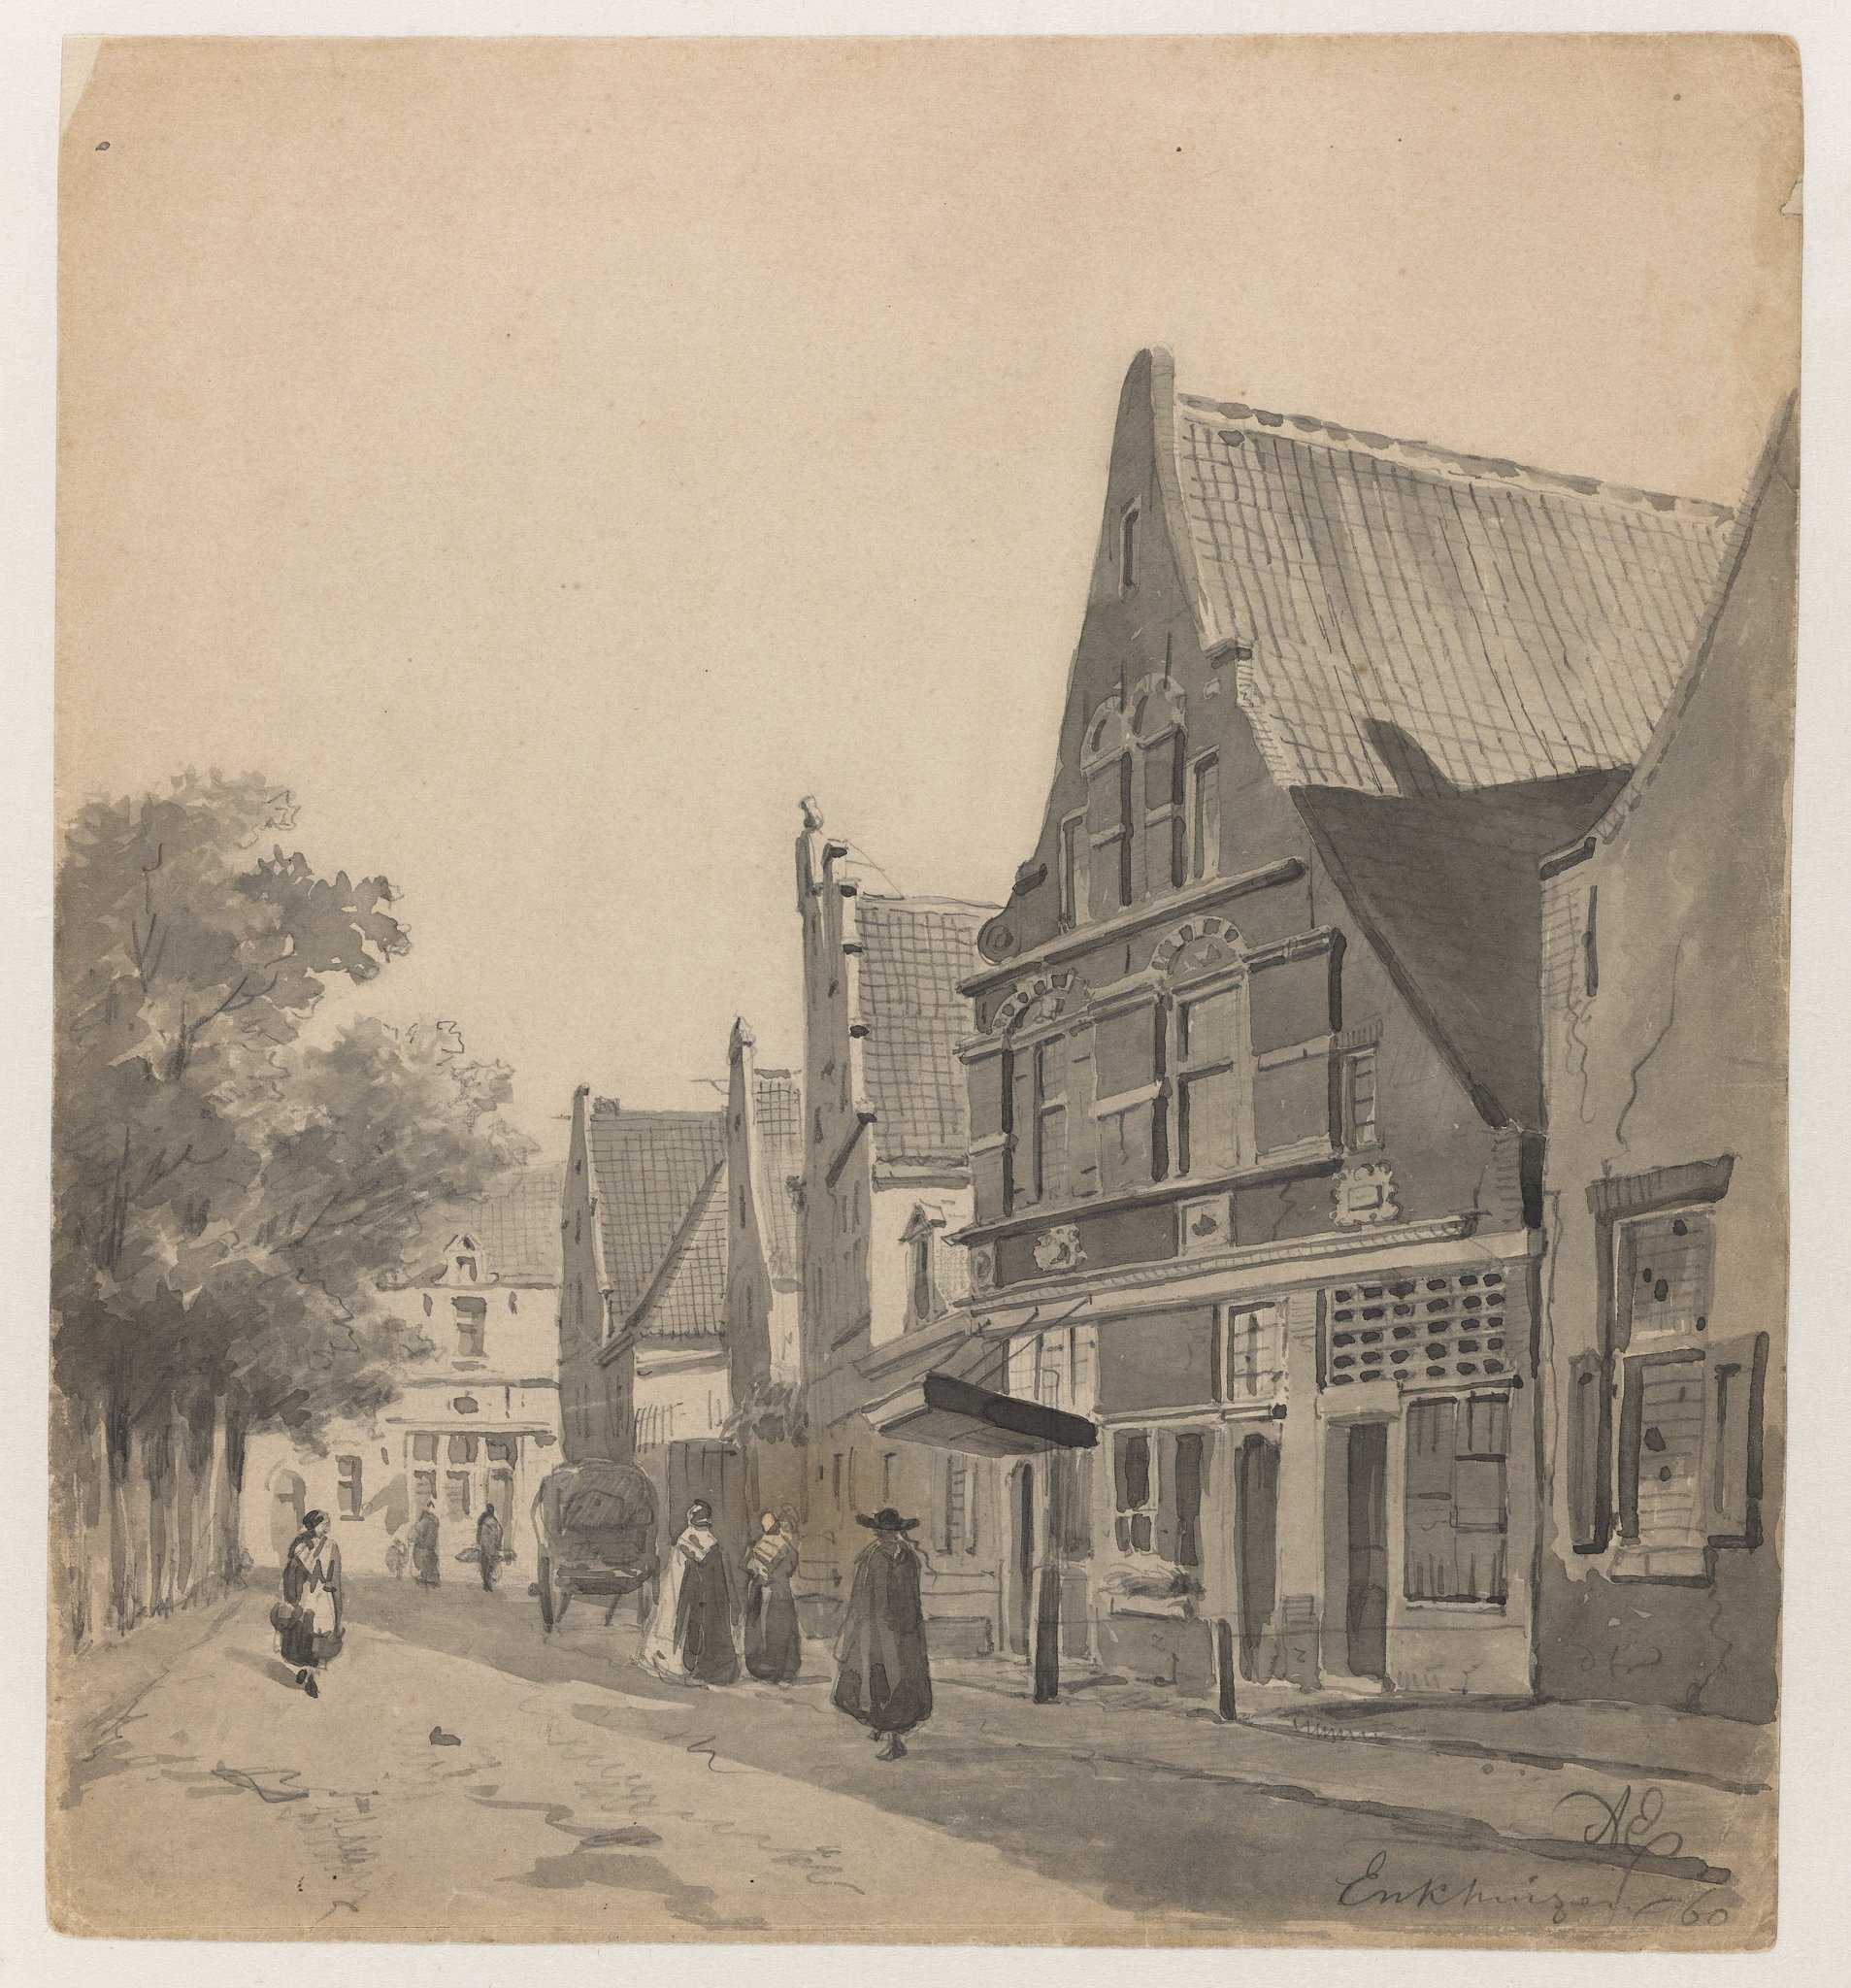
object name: drawing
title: Gezicht op de Zuiderhavendijk te Enkhuizen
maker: adrianus eversen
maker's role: draughtsman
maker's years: 1818-1897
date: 1860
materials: paper, pencil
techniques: brush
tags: enkhuizen